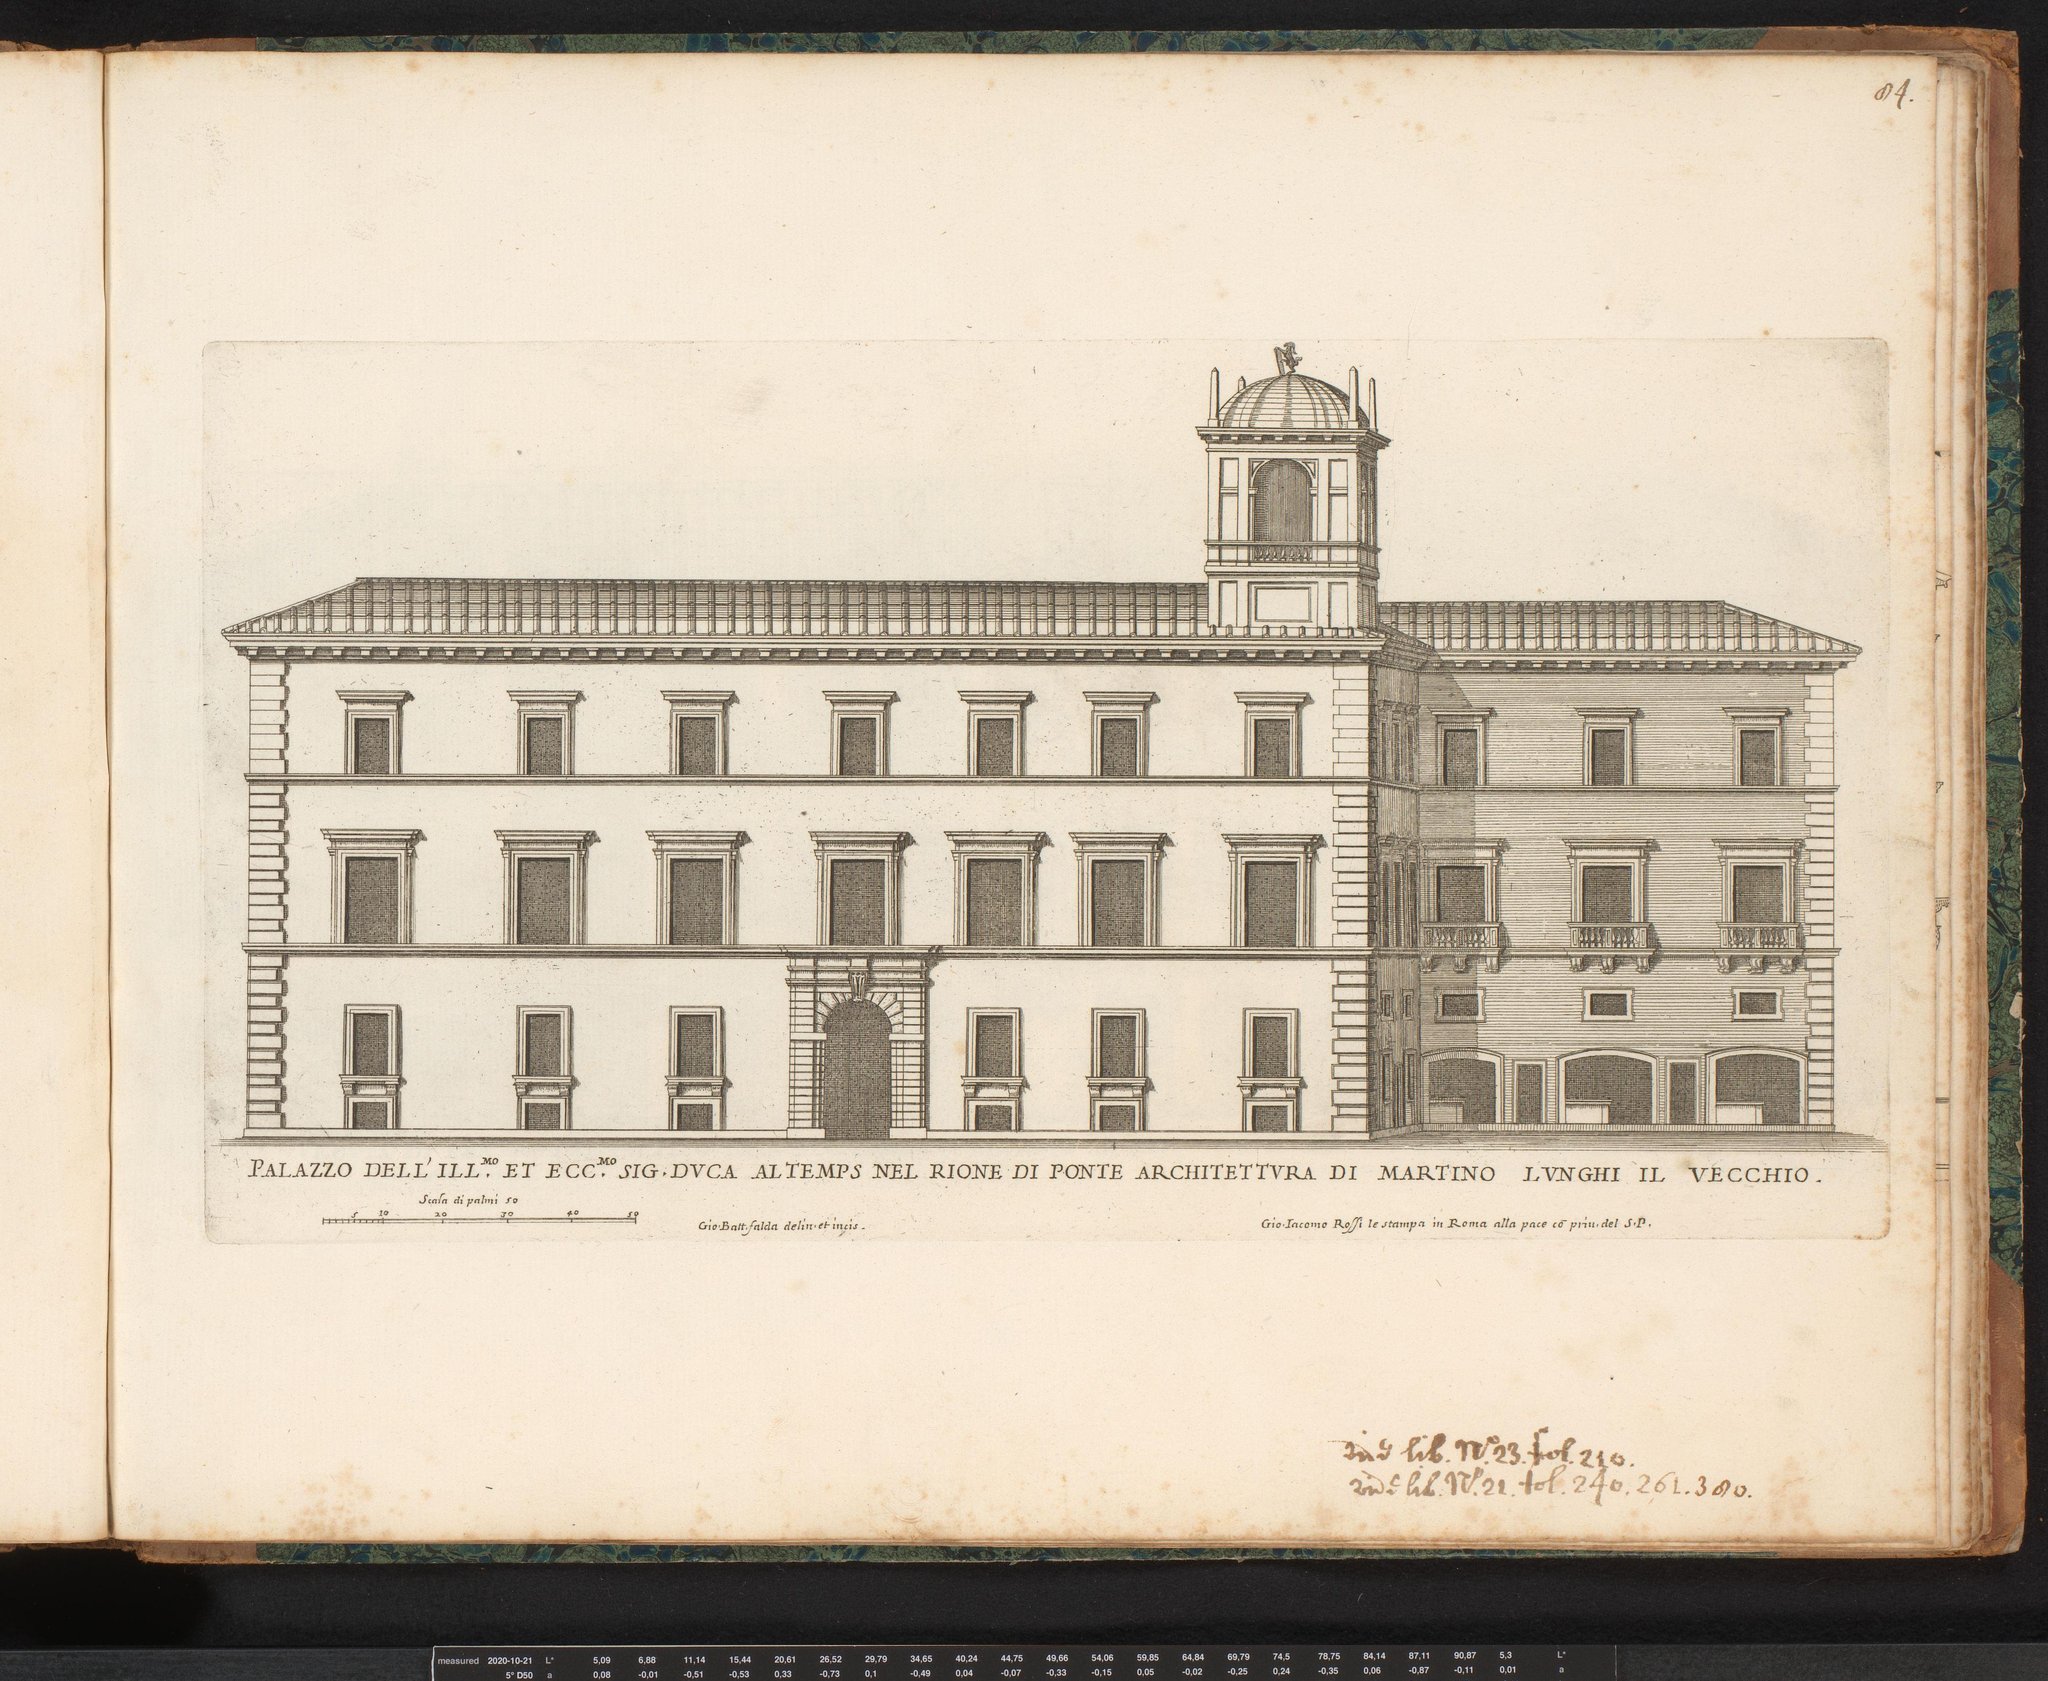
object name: print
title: Façade van Palazzo Altemps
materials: paper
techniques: etching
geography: rome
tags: palace, façade (of house or building)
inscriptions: number: ‘84’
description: Deze prent maakt deel uit van de reeks getiteld: Palazzi di Roma. Deze reeks bestaat uit twee boeken. Boek één getiteld: Palazzi di Roma dei più celebri architetti..., bestaat uit 44 prenten die worden toegeschreven aan Giovanni Battista Falda (naam staat enkel op prent 27) en uitgegeven door Giovanni Giacomo de'Rossi. Deze 44 prenten zijn bekend in twee staten (met en zonder nummer). Boek twee getiteld: Nuovi disegni dell'architetture... libro secondo, bevat 66 prenten door Giovanni Battista Falda en Simone Felice. Deze 66 prenten zijn bekend in twee staten (met en zonder nummer).